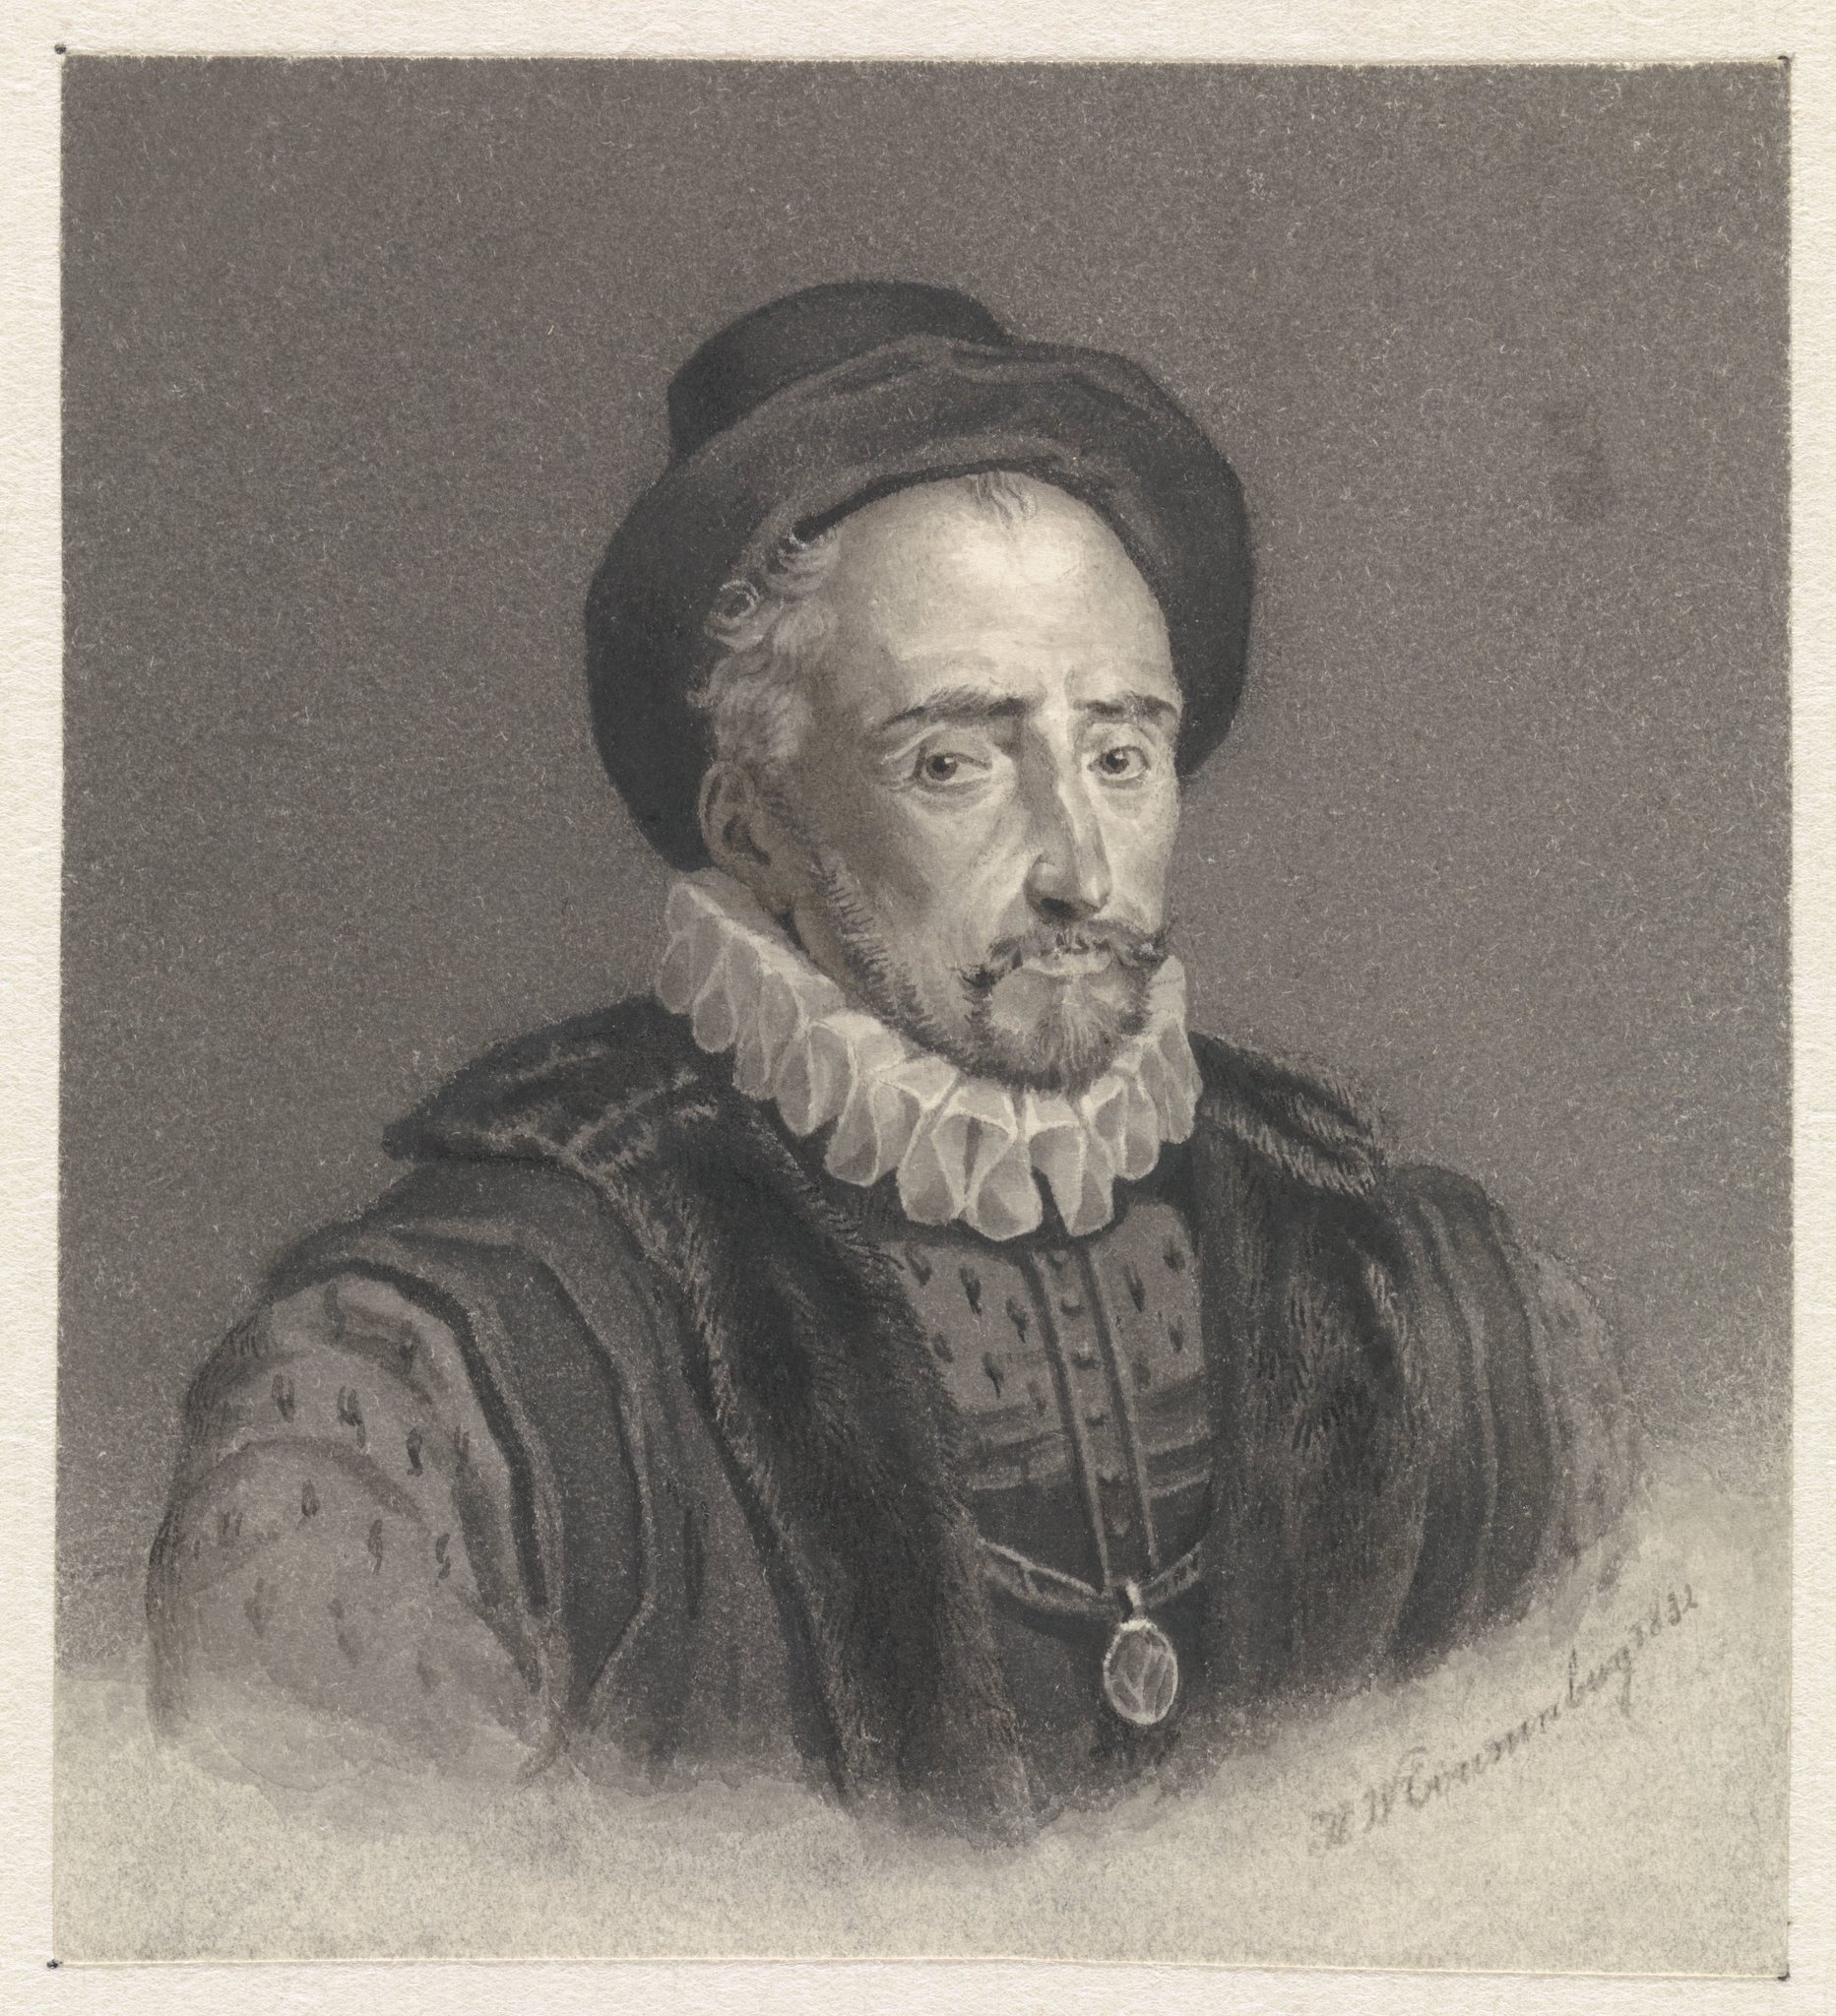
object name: drawing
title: Historisch mansportret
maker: henricus wilhelmus couwenberg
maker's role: draughtsman, print maker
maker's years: 1814-1845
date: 1832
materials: paper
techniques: brush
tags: anonymous historical person portrayed alone